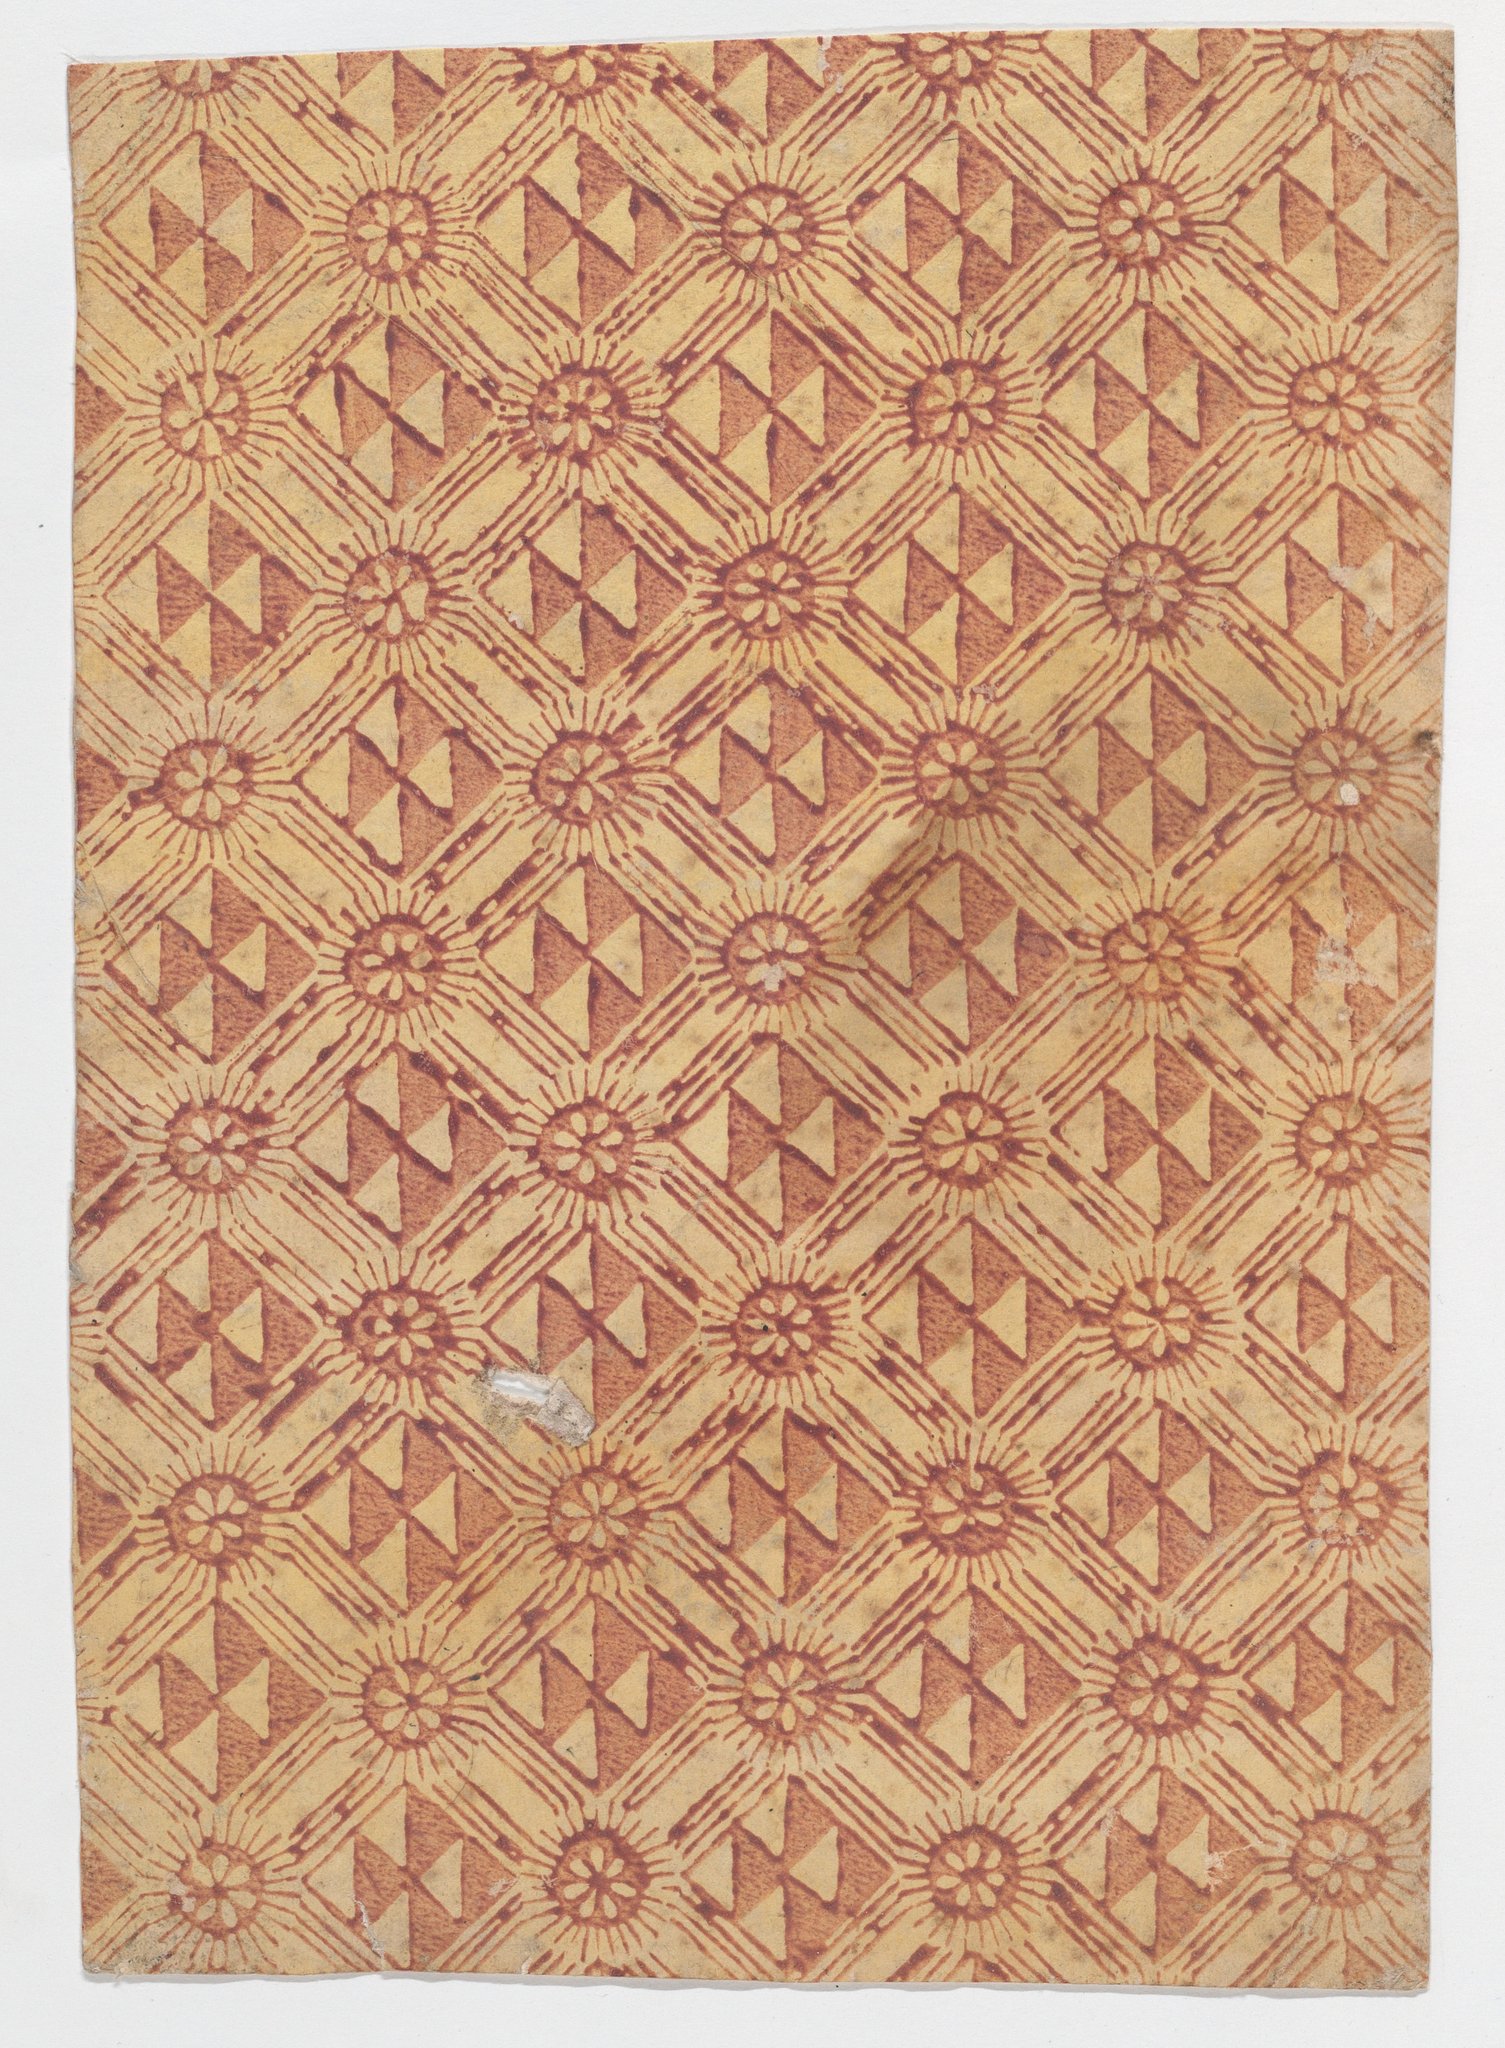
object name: print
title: Sheet with overall pattern of triangles and rosettes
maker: Anonymous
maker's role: artist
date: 1801-1900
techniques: relief print